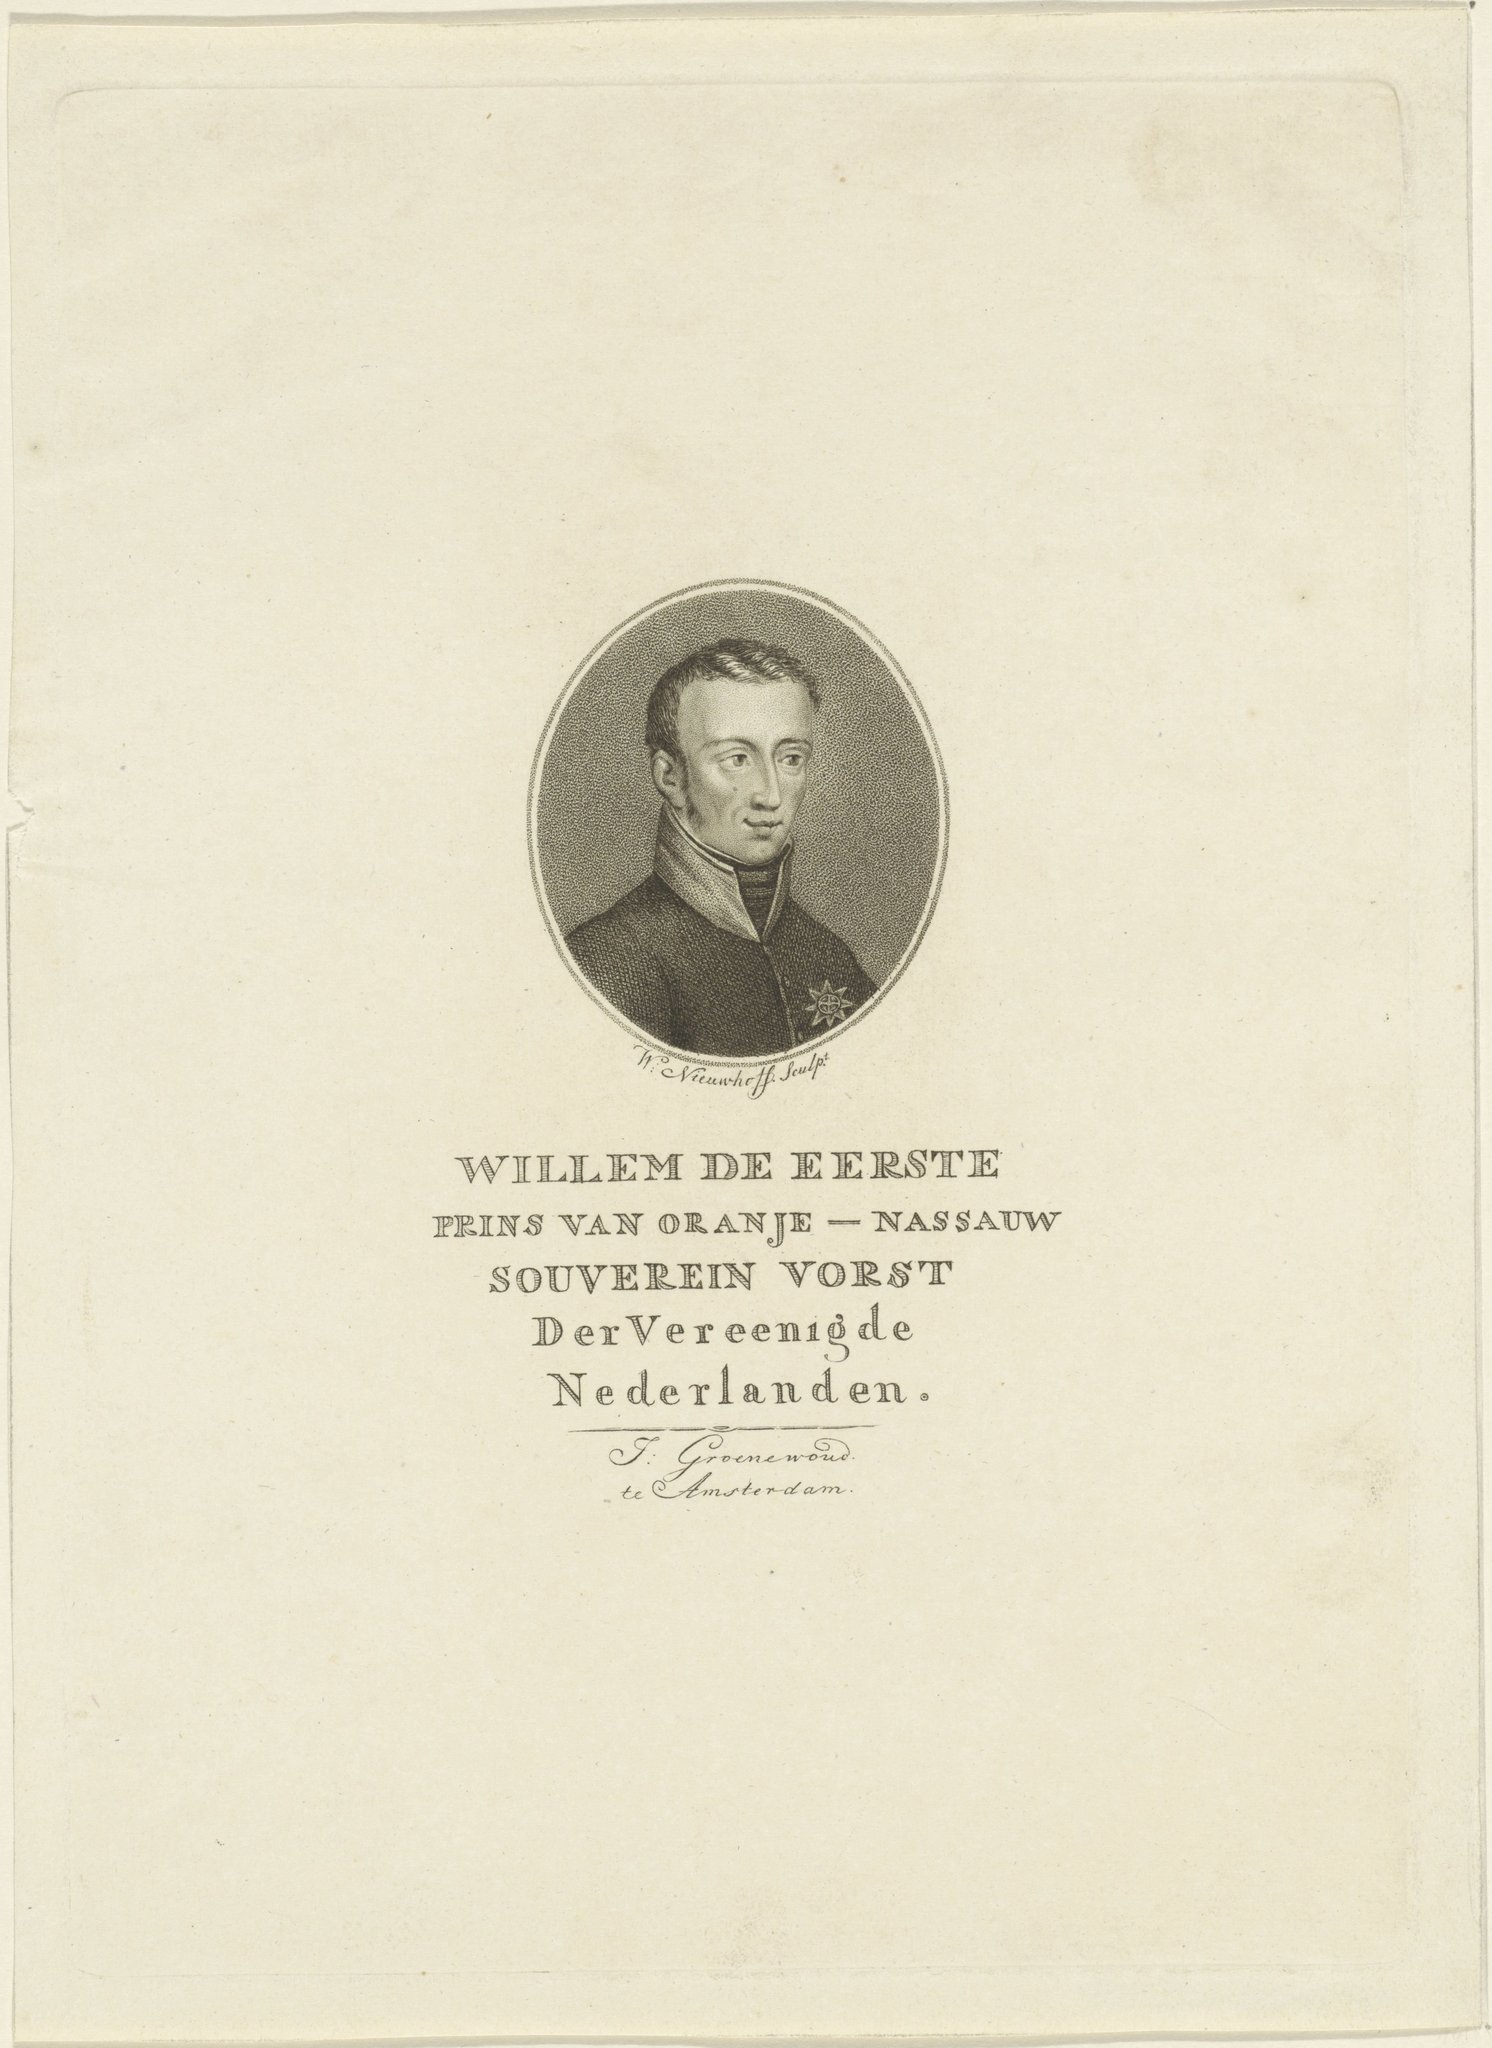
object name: print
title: Portret van Willem I Frederik, koning der Nederlanden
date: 1813-1815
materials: paper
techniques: engraving, etching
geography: amsterdam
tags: the hague, berlin, william i of the netherlands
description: De hier vermelde titel verwijst naar de hoogst verkregen titel van de geportretteerde, niet per se naar de titel die de geportretteerde op deze voorstelling draagt.